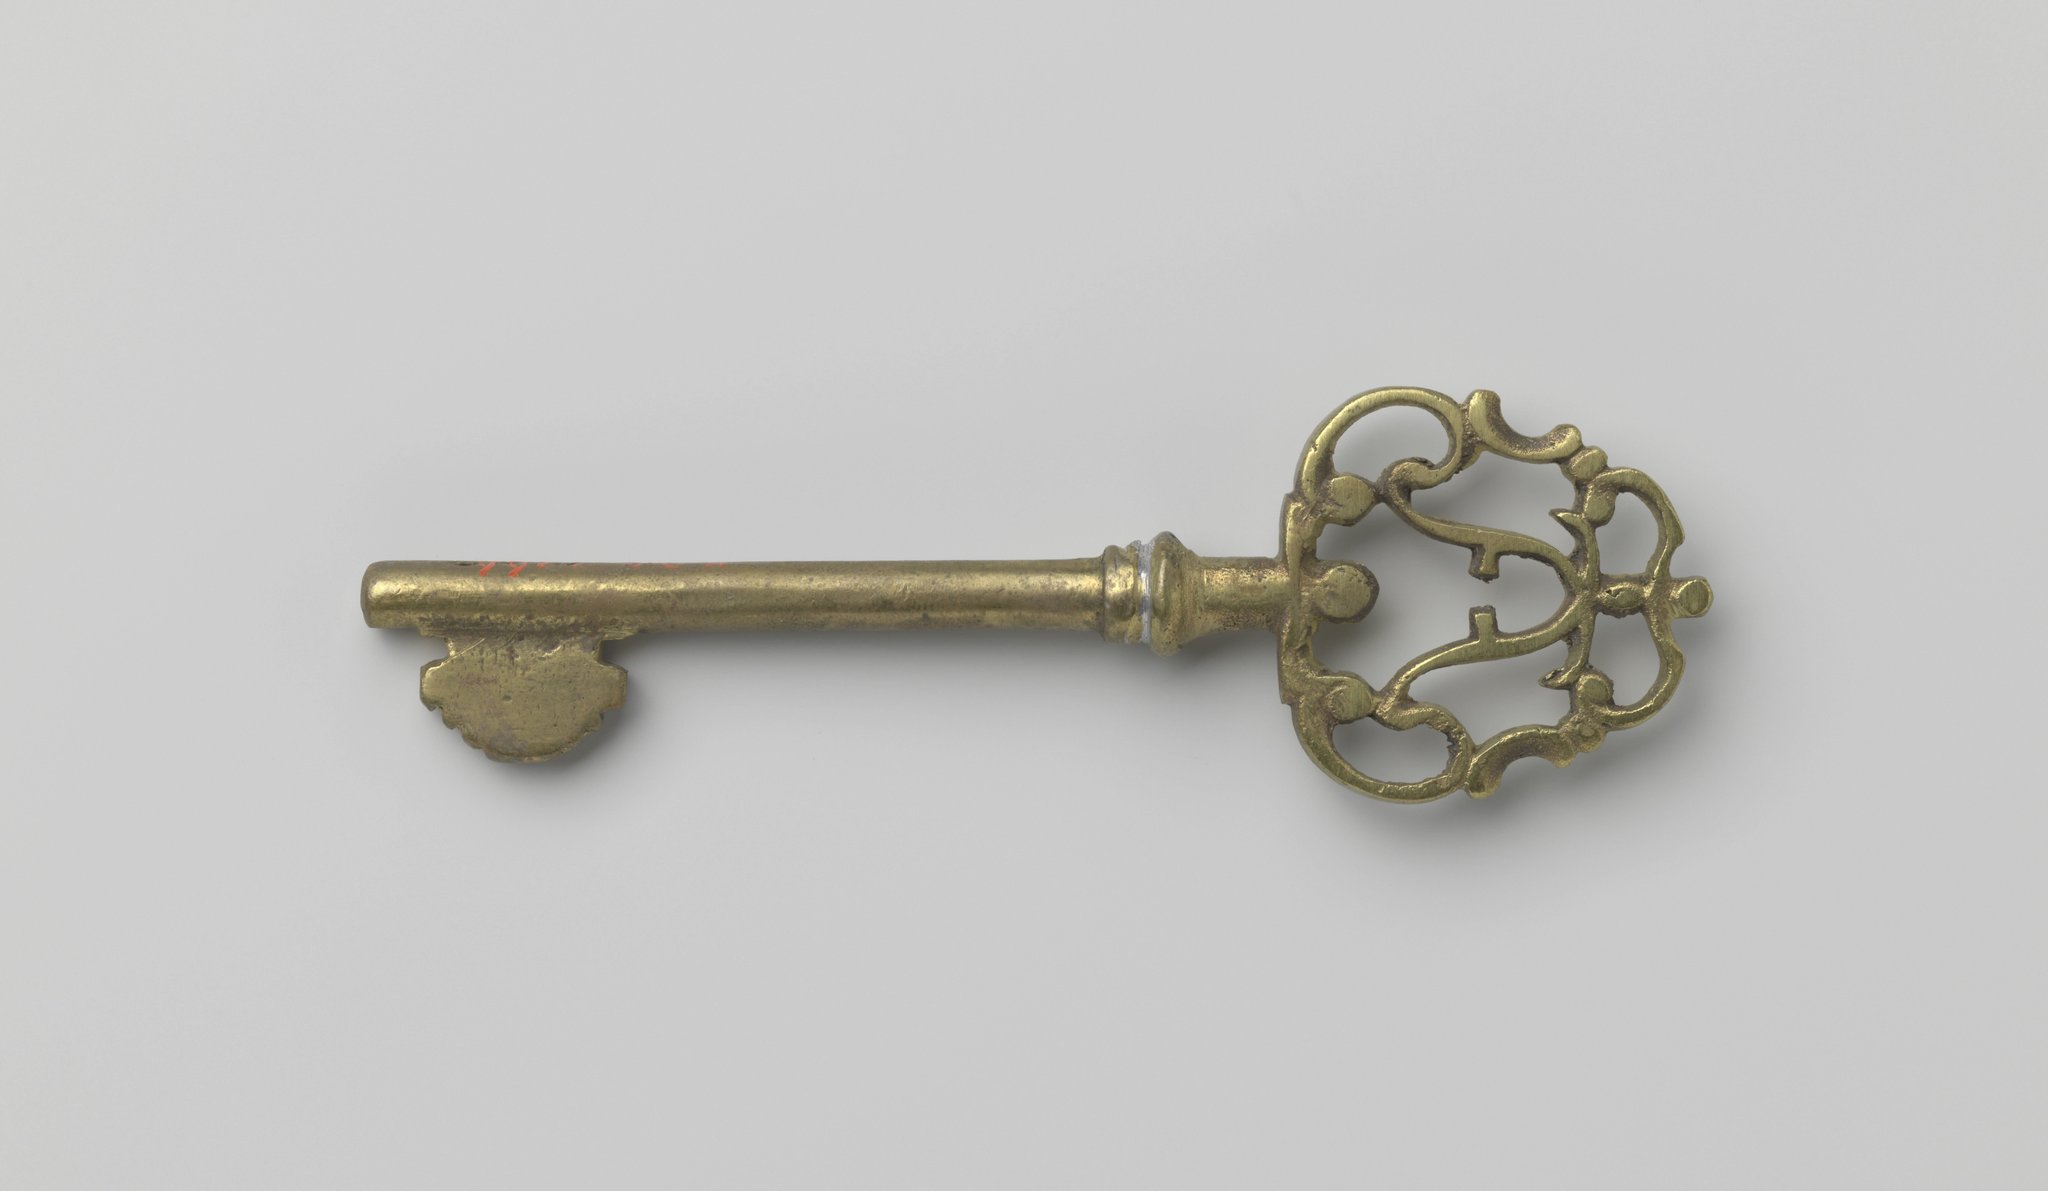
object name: key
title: Sleutel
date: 1400-1950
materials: copper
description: Sleutel met de letter A in de door voluten gevormde greep. Baard bijlvormig.